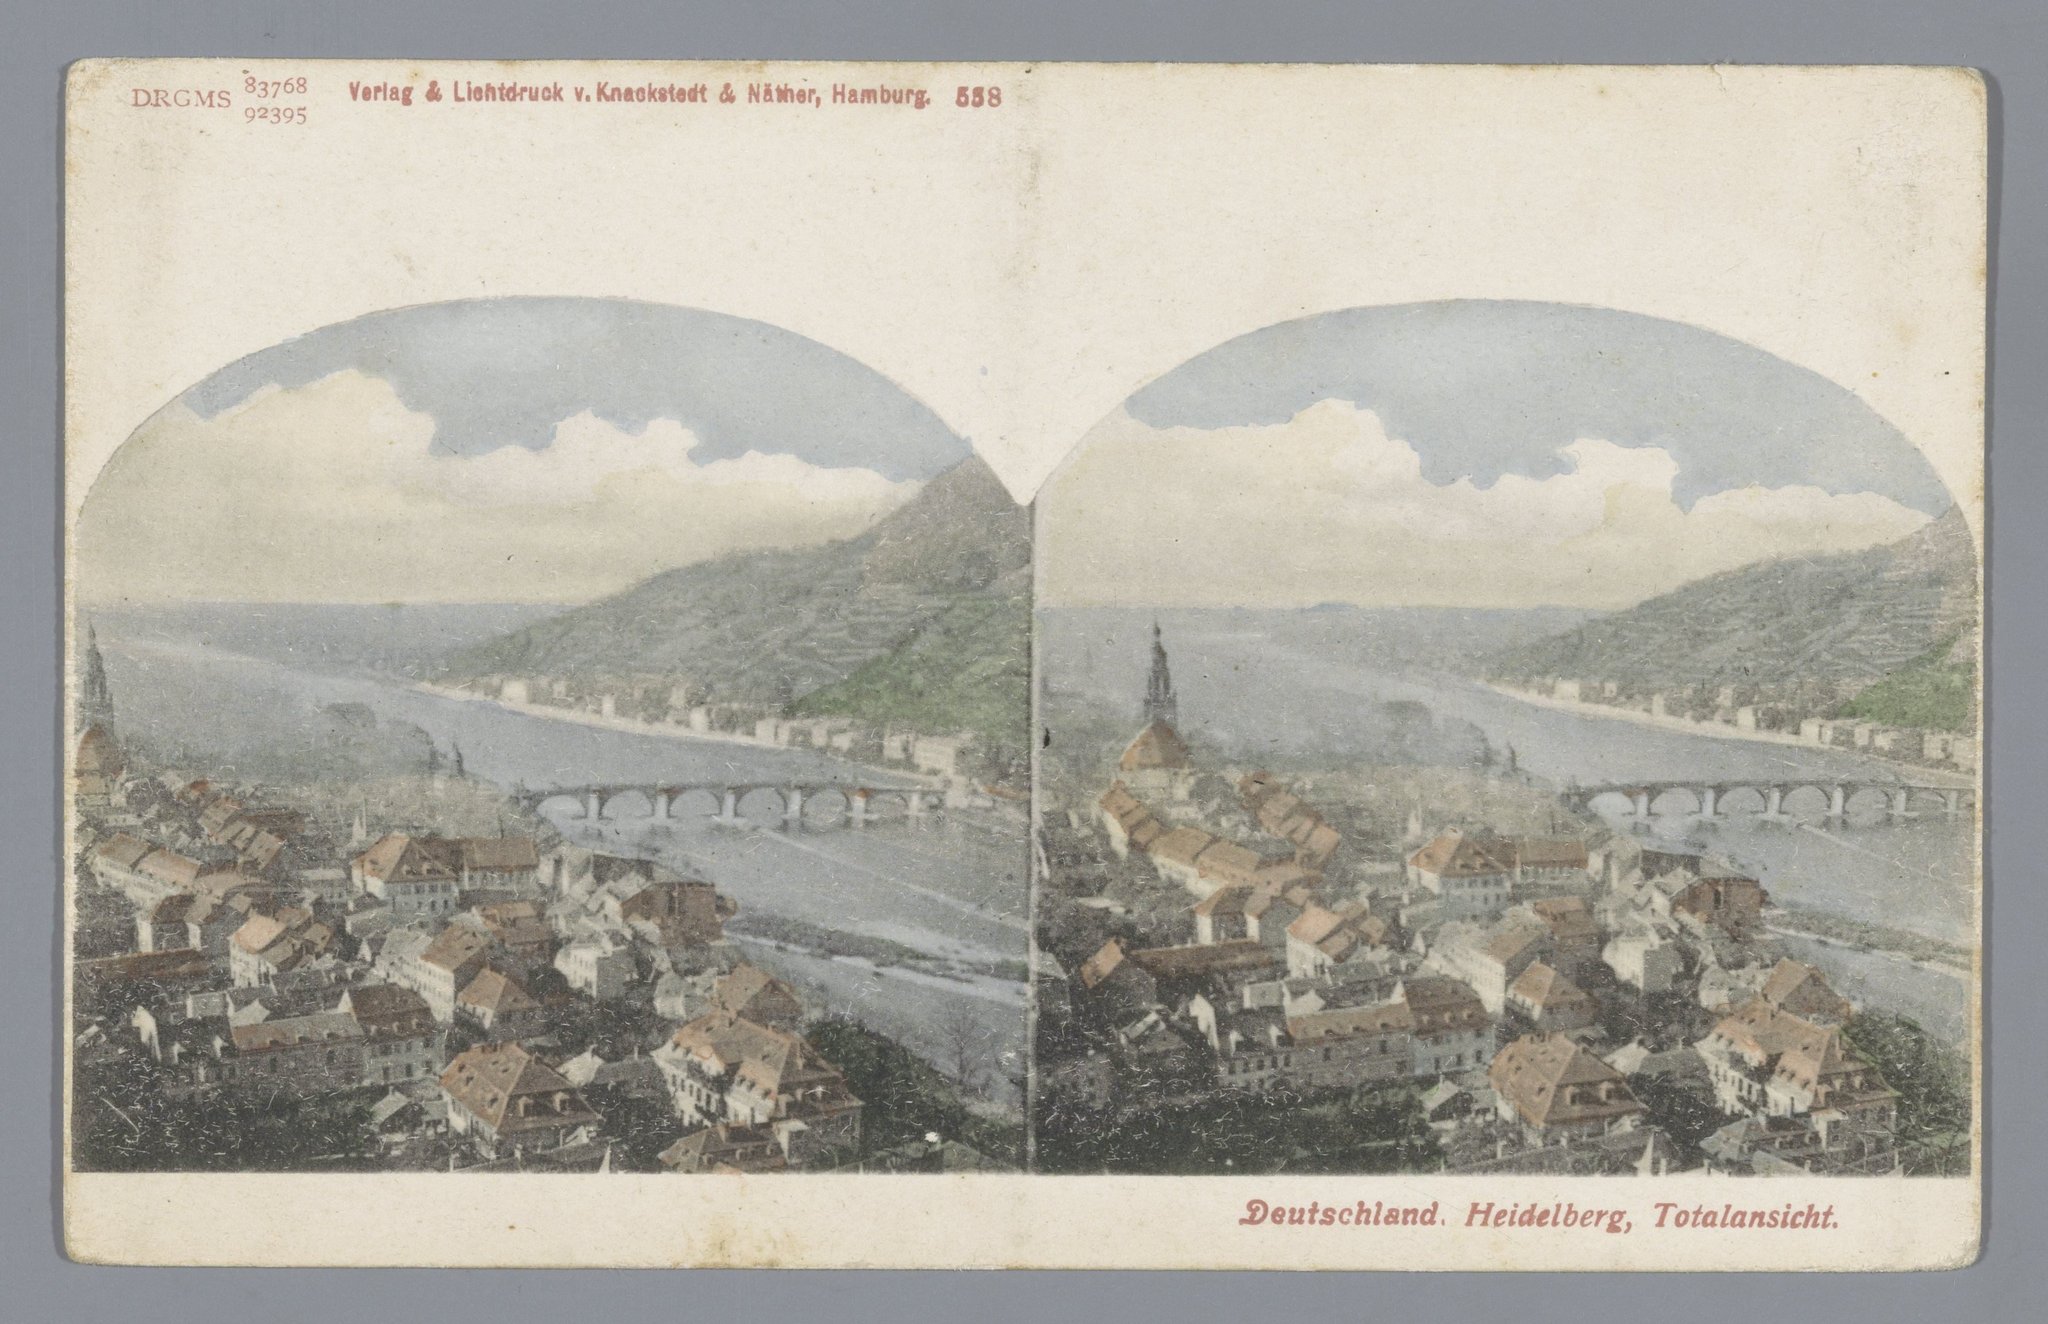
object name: photomechanical print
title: Gezicht op Heidelberg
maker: Anonymous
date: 1889-1905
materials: cardboard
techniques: photograph, hand coloring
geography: hamburg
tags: city-view in general; 'veduta', bridge in city across river, canal, etc.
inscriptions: inscription: ‘Post-Karte’, number: ‘558’, inscription: ‘DRGMS 83768/ 92395’